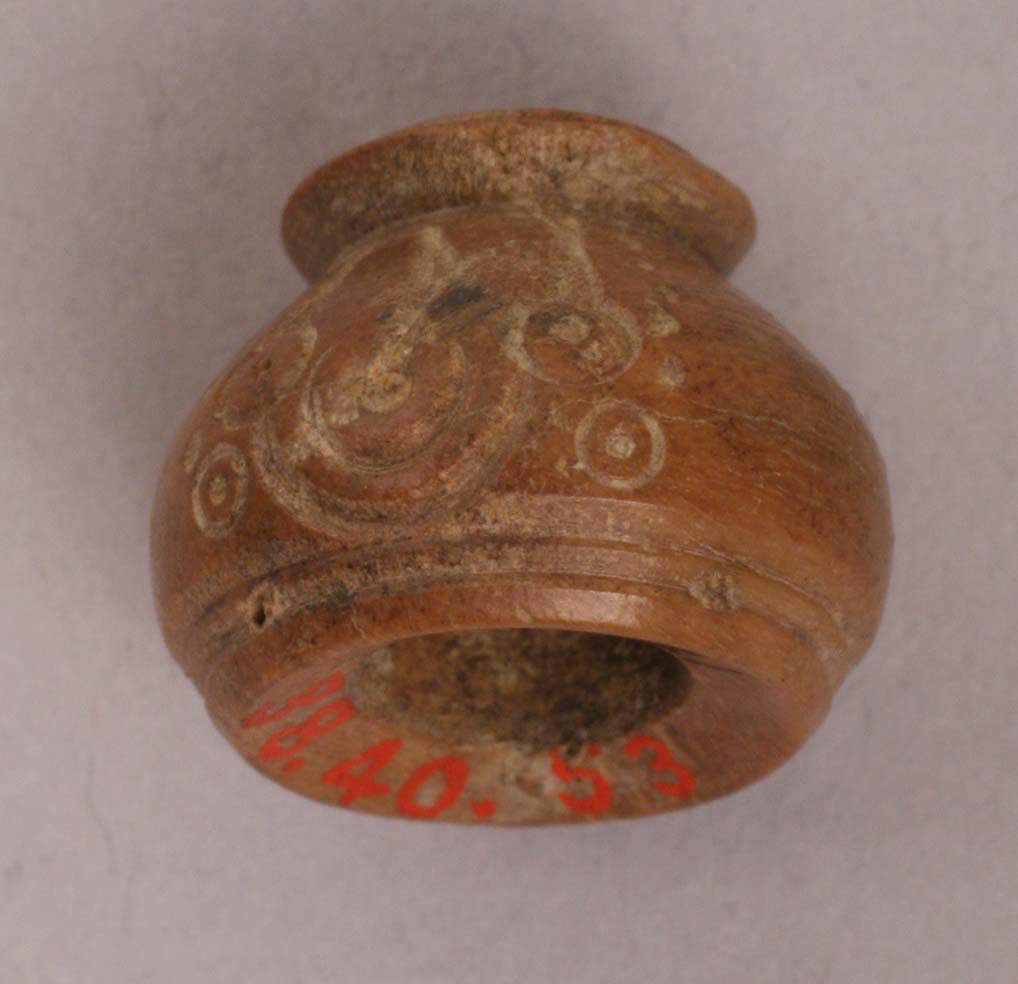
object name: button or bead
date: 801-1000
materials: bone, paint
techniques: incising, inlay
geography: iran